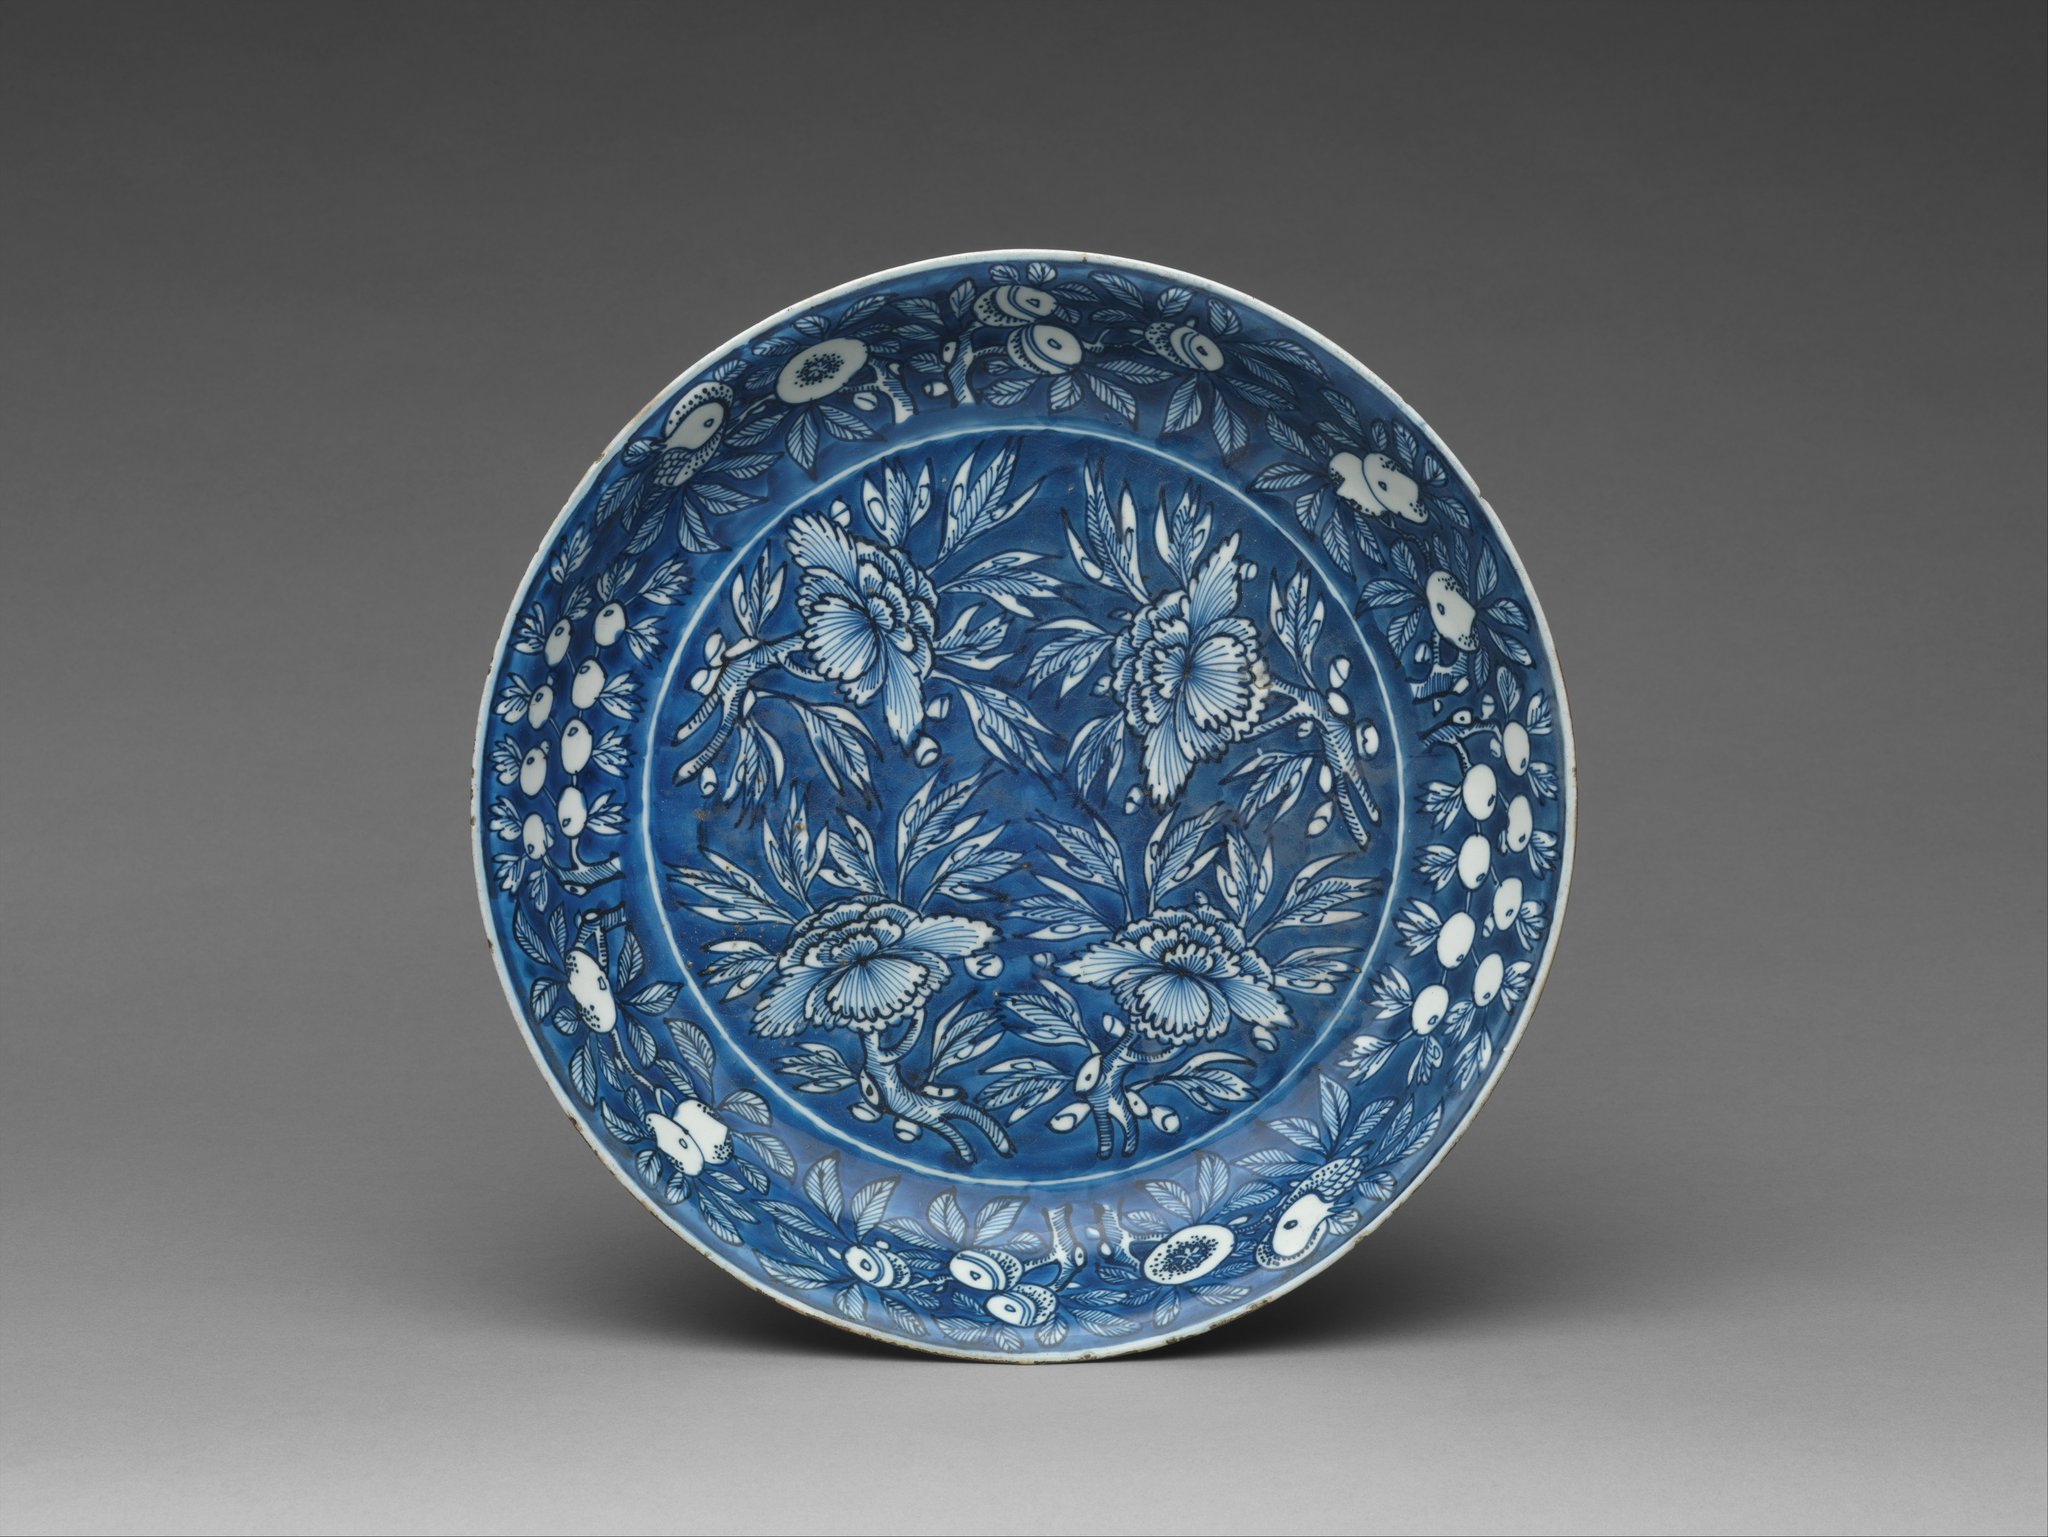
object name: dish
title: Dish with Flowering Branches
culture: chinese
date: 1567-1633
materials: cobalt, glaze, porcelain